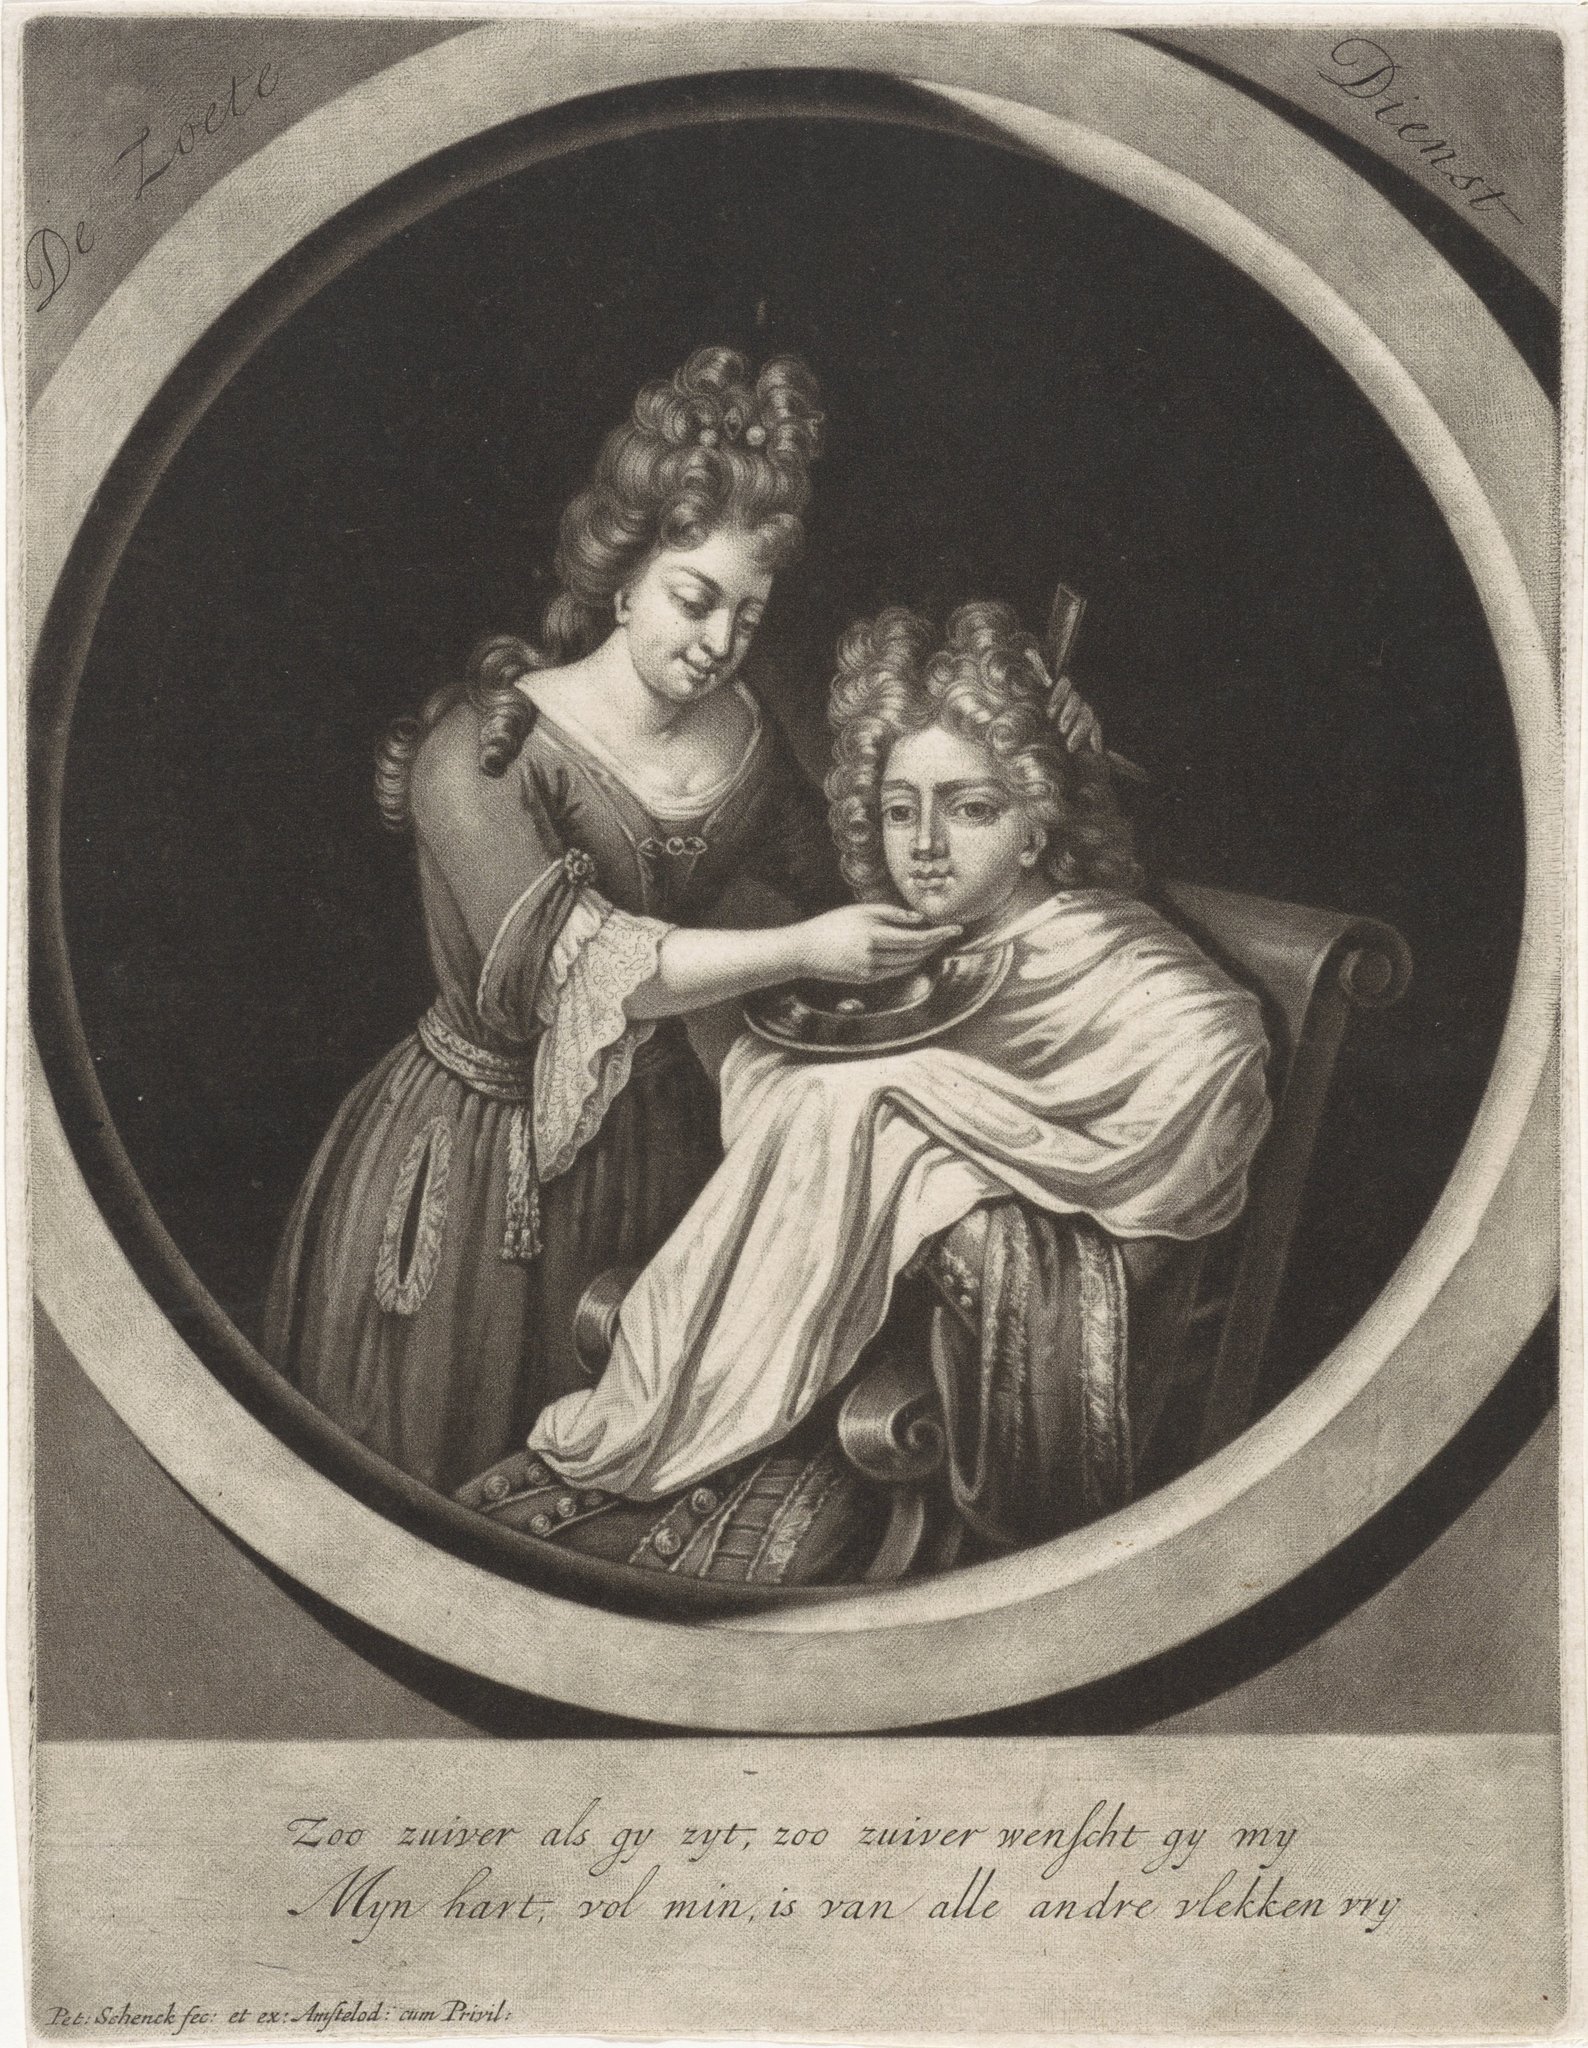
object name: print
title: De Zoete Dienst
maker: pieter schenk (i)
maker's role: print maker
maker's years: 1660-1711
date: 1670-1713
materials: paper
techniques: engraving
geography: amsterdam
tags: shaving, being shaved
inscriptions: collector's mark: Lugt 2228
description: Een jongeman wordt geschoren door een jonge vrouw. Zij houdt het scheerbekken onder zijn kin.